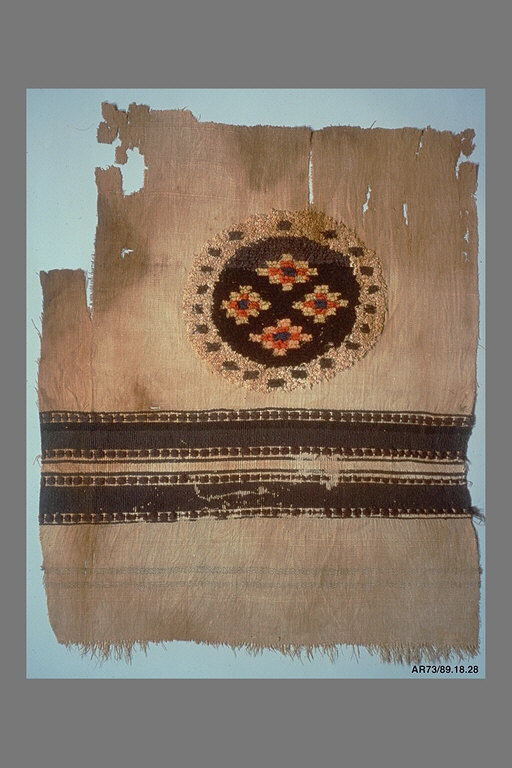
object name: textile fragment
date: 301-500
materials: linen, wool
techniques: weave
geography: egypt